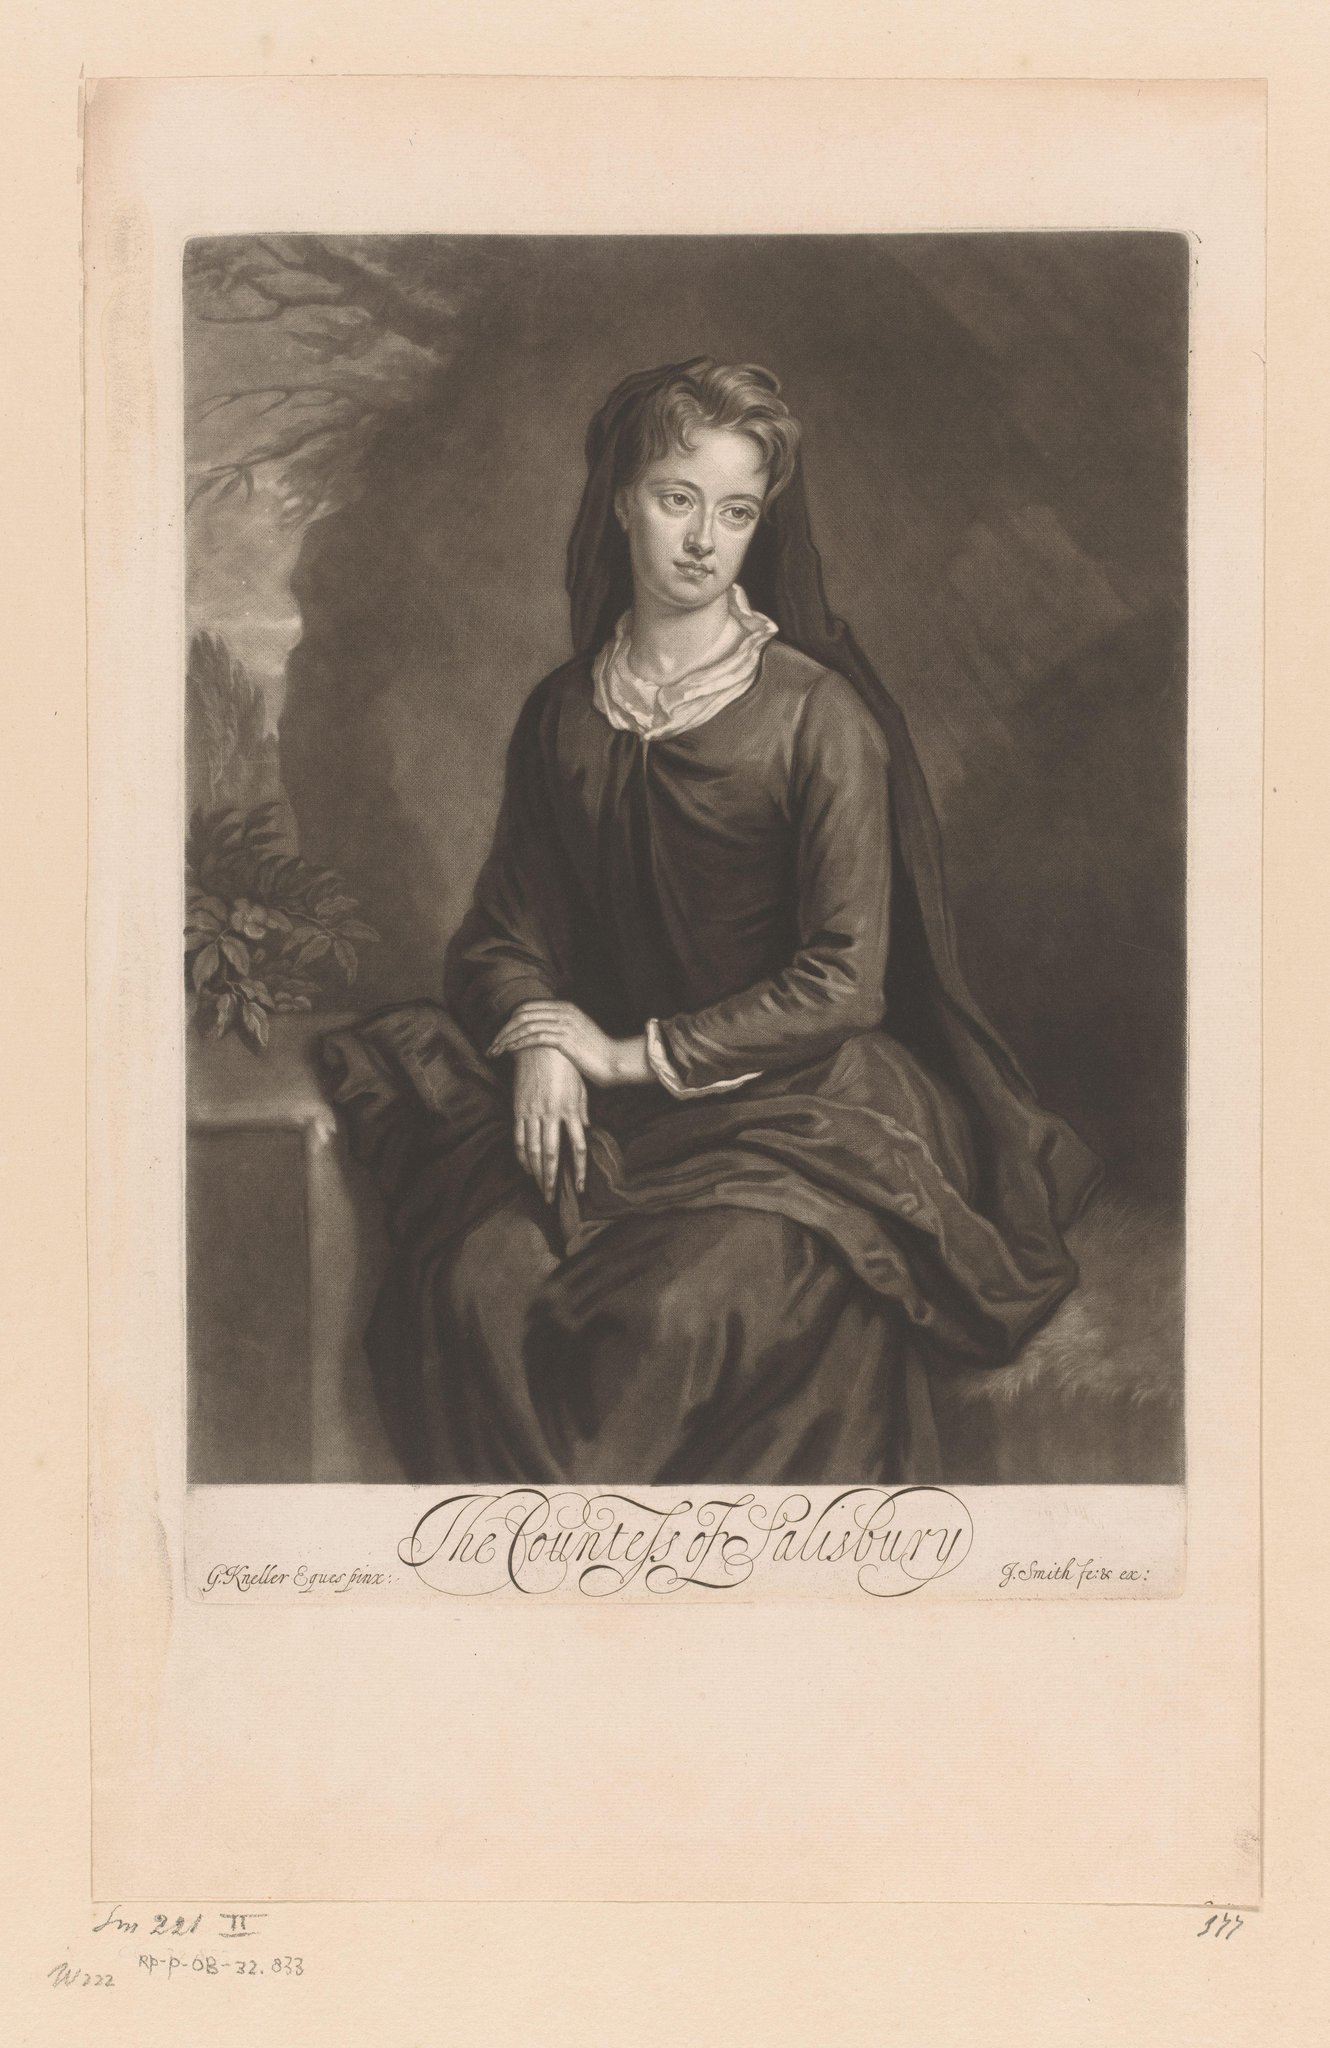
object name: print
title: Portret van Francis Cecil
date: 1680-1742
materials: paper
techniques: mezzotint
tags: historical persons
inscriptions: collector's mark: Lugt 240